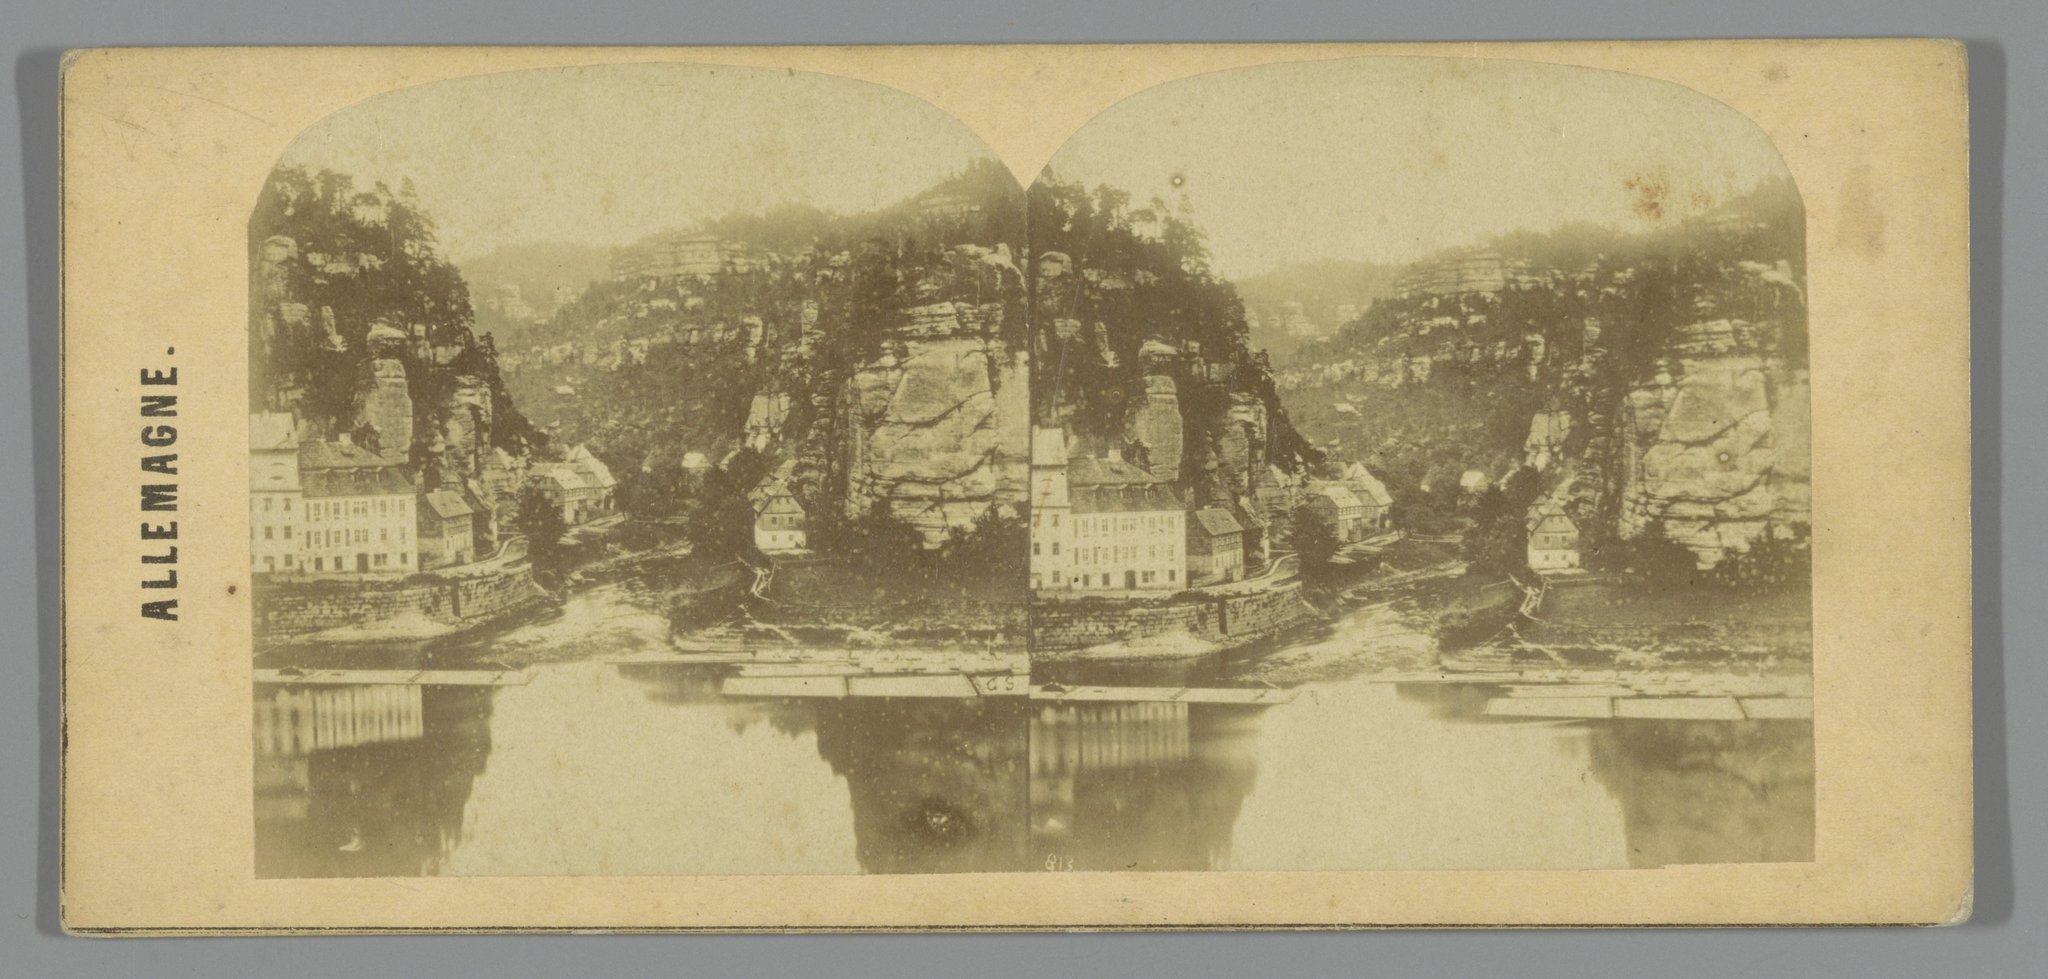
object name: stereograph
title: Allemagne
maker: Anonymous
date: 1860-1870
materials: cardboard, photographic support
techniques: albumen print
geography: germany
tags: city-view in general; 'veduta', river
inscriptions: number: ‘813’, inscription: ‘Suisse Saxonne, Herrenskretschen’